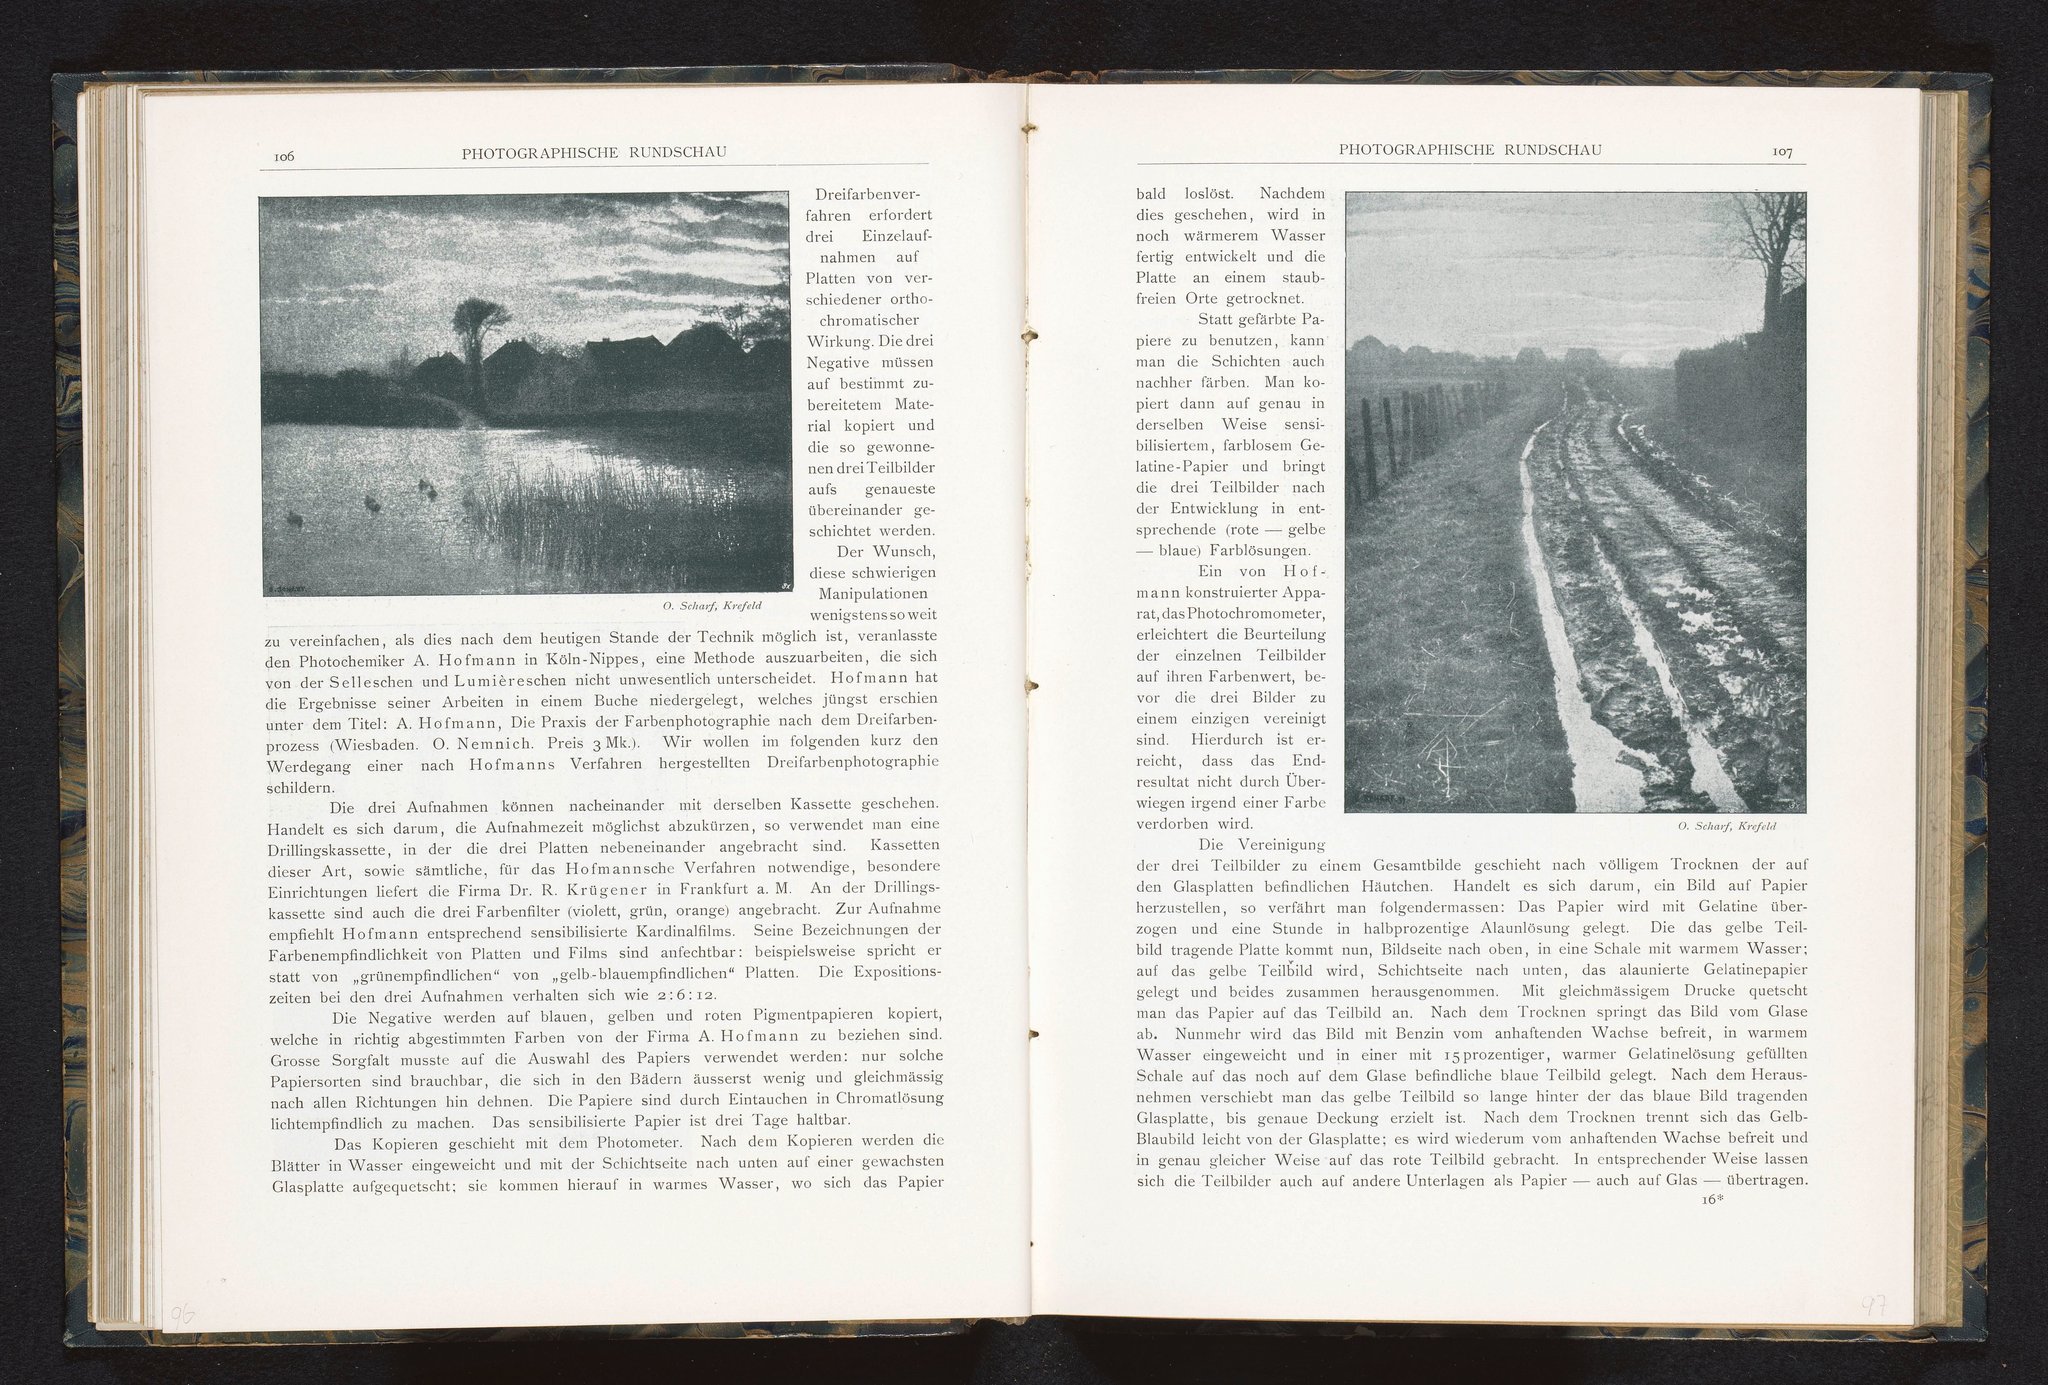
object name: photomechanical print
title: Gezicht op een pad met banden- of wielsporen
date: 1895-1900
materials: paper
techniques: autotype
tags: wheel track, road, path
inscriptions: monogram: ‘BX’